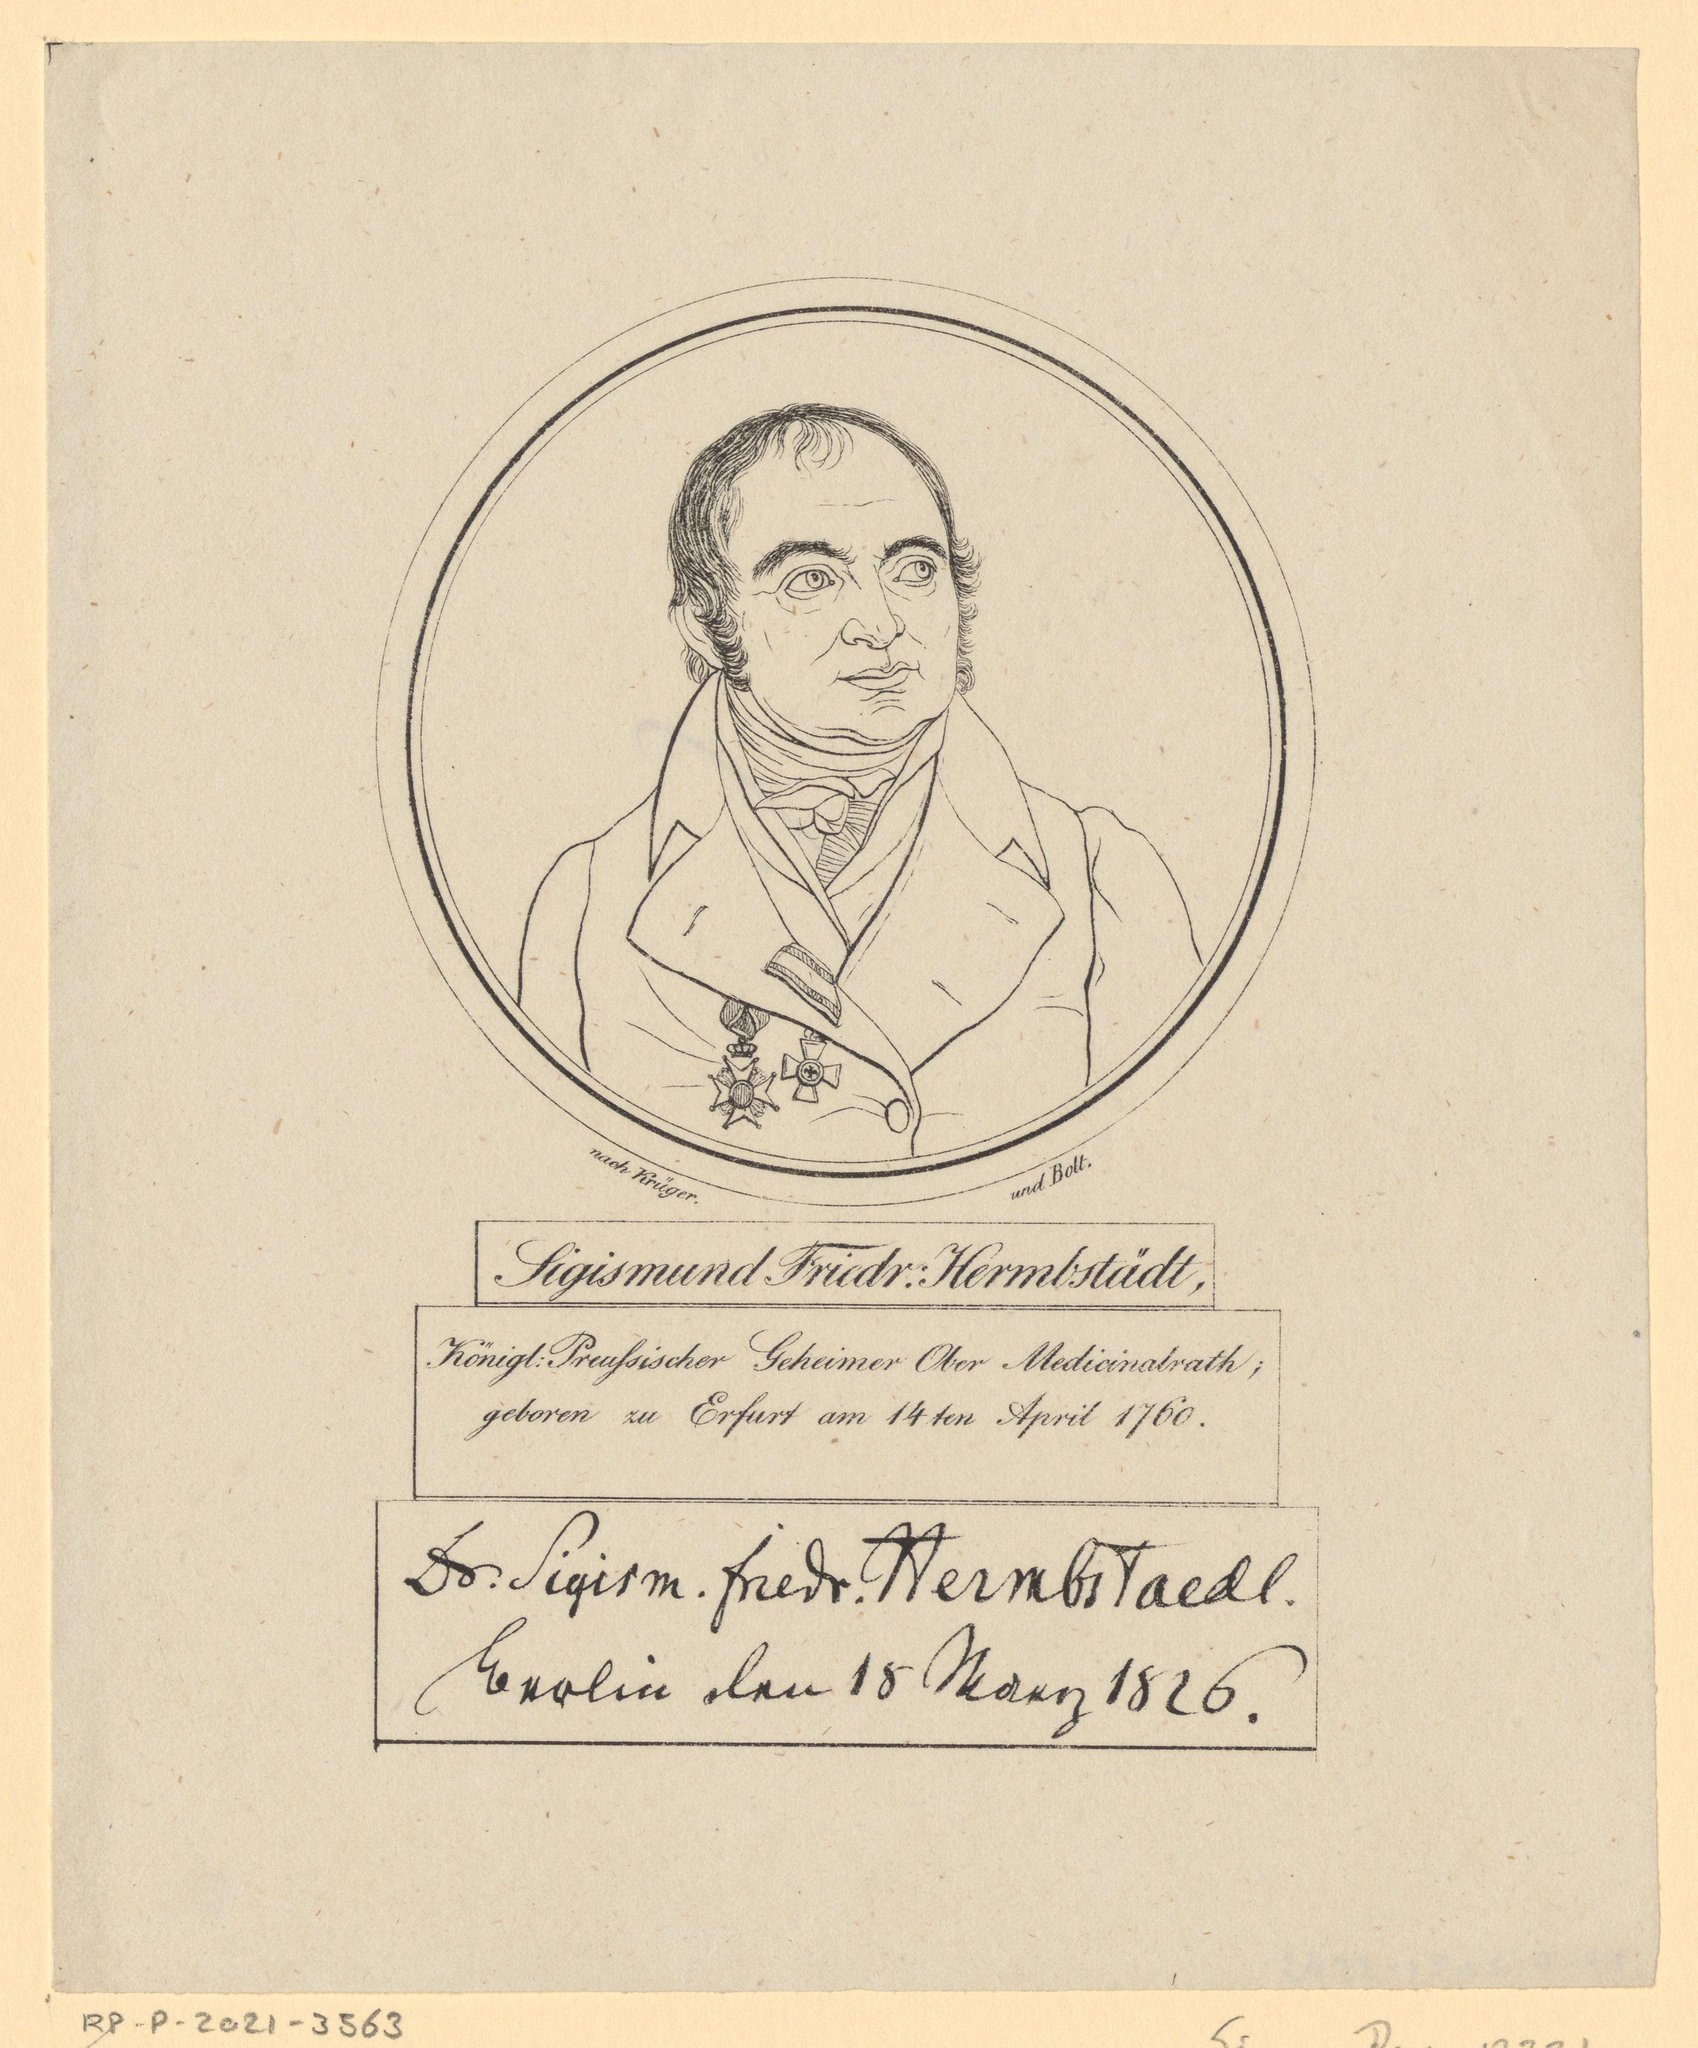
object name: print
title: Portret van Sigismund Friedrich Hermbstädt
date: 1826-1849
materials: paper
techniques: lithograph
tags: sigismund friedrich hermbstaedt, pharmacist, druggist, apothecary; pharmacy, drugstore, dispensing chemist, historical persons